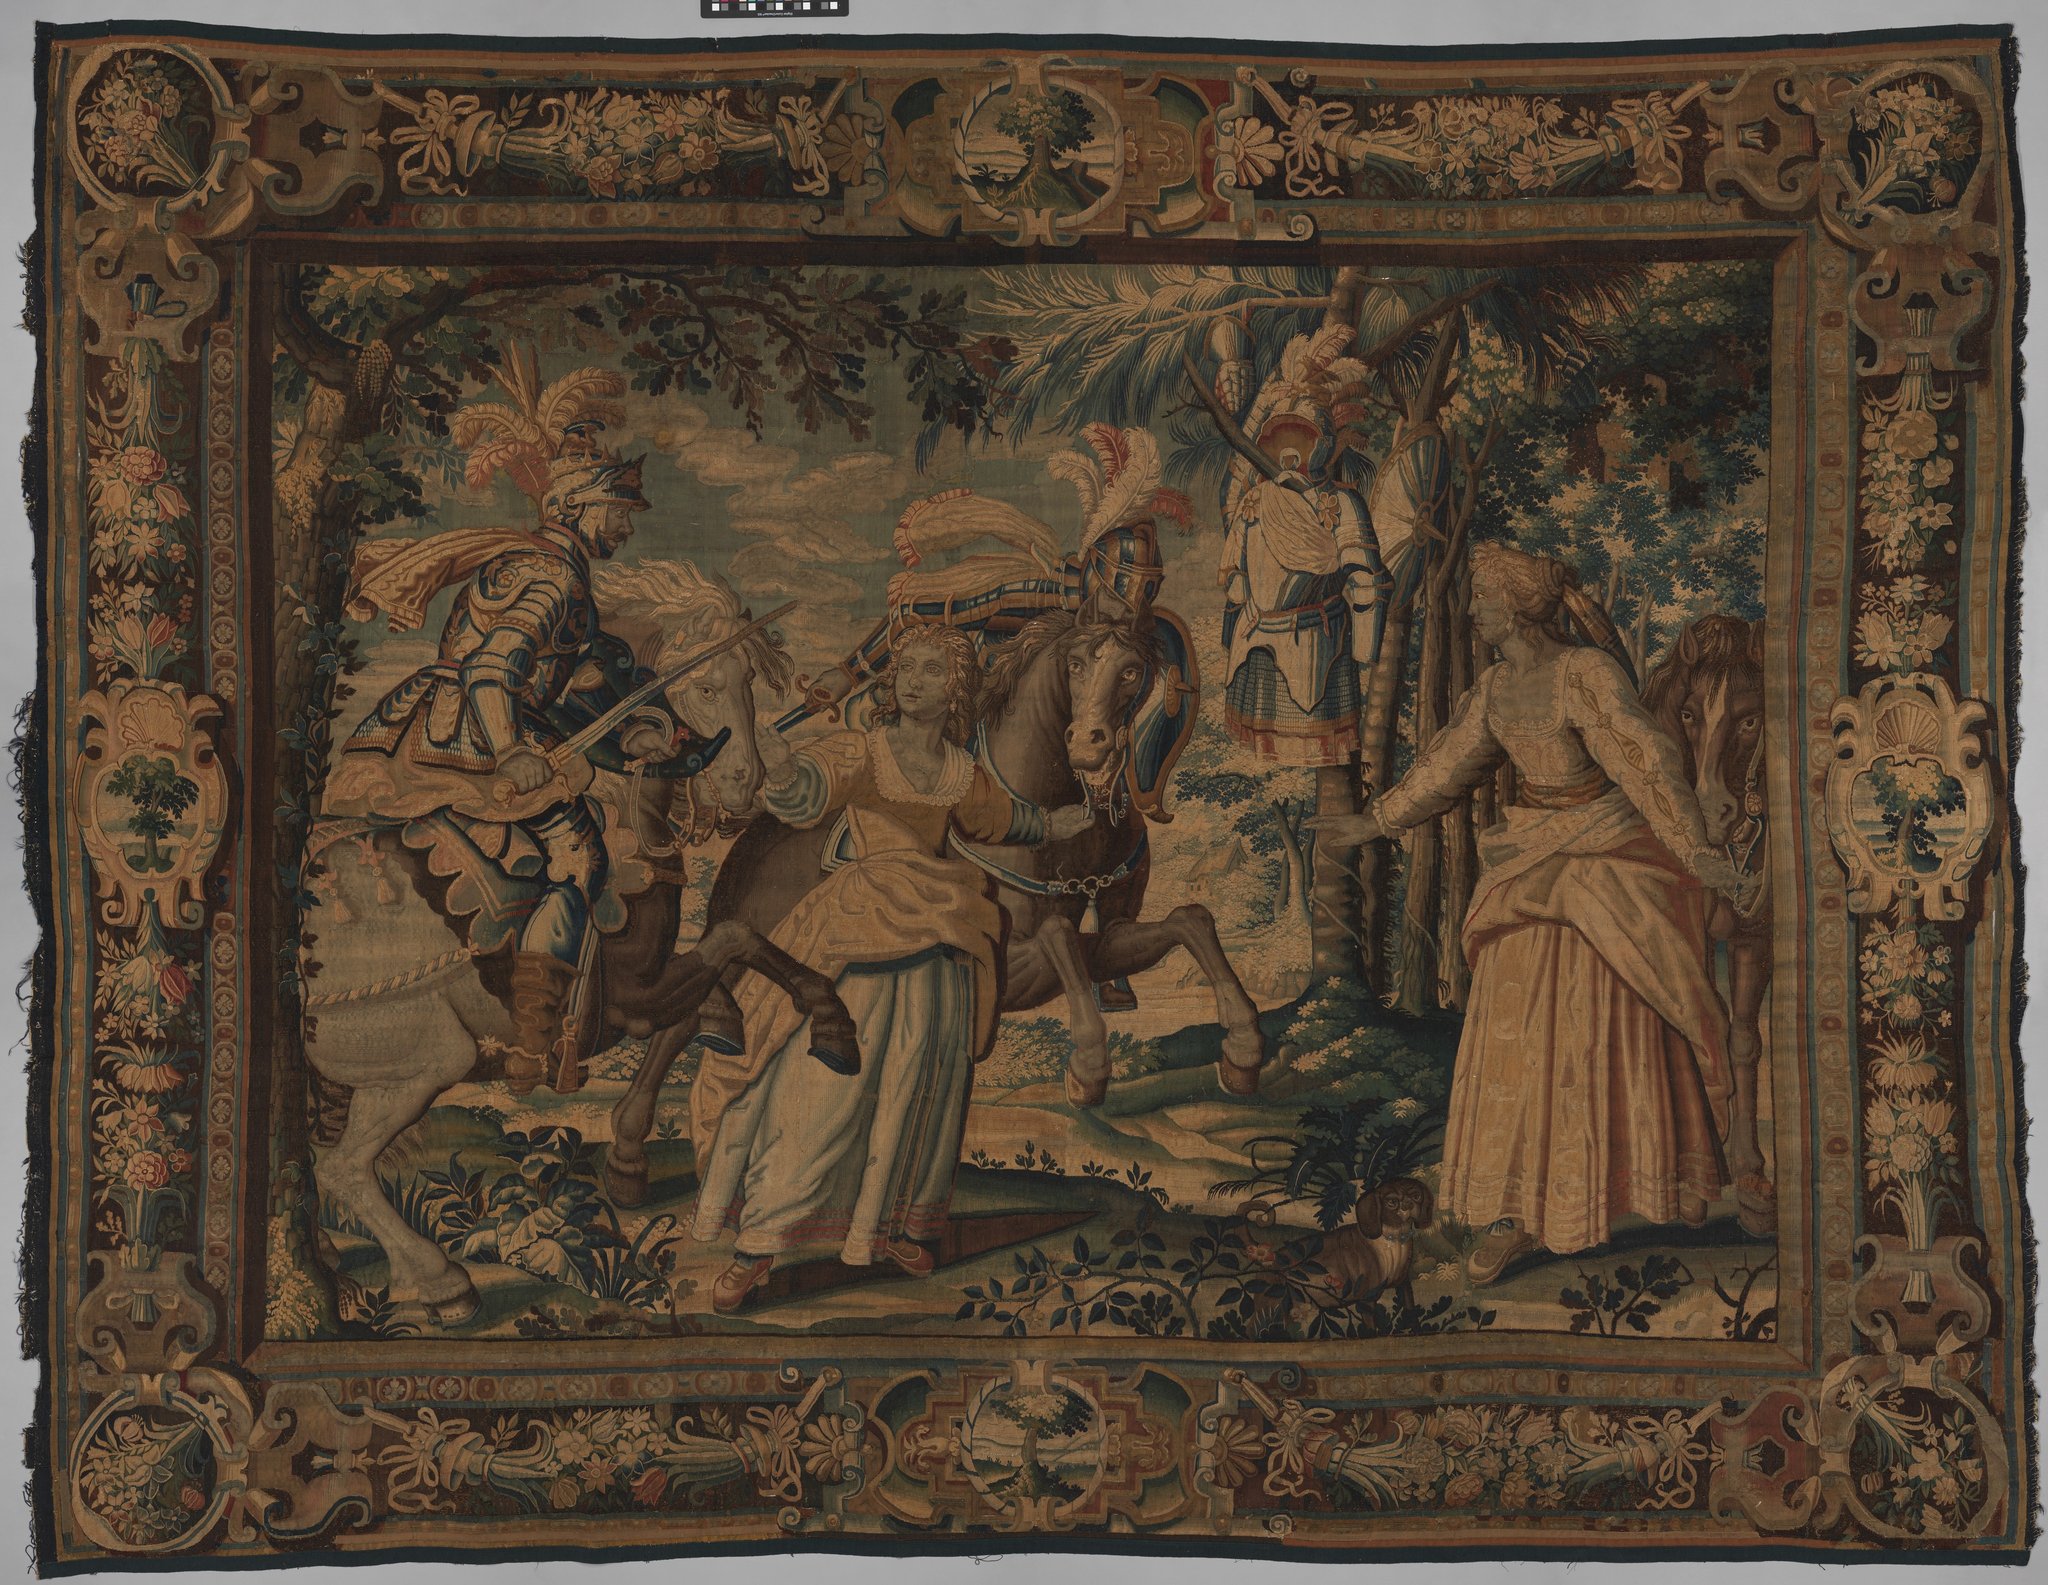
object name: tapestry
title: The Combat of Manricardo and Zerbino from a set illustrating Ariosto's Orlando Furioso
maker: raphaël de la planche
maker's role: manufactory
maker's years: 1625-1665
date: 1630-1650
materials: silk, wool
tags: wars,kings,women,horses,knights